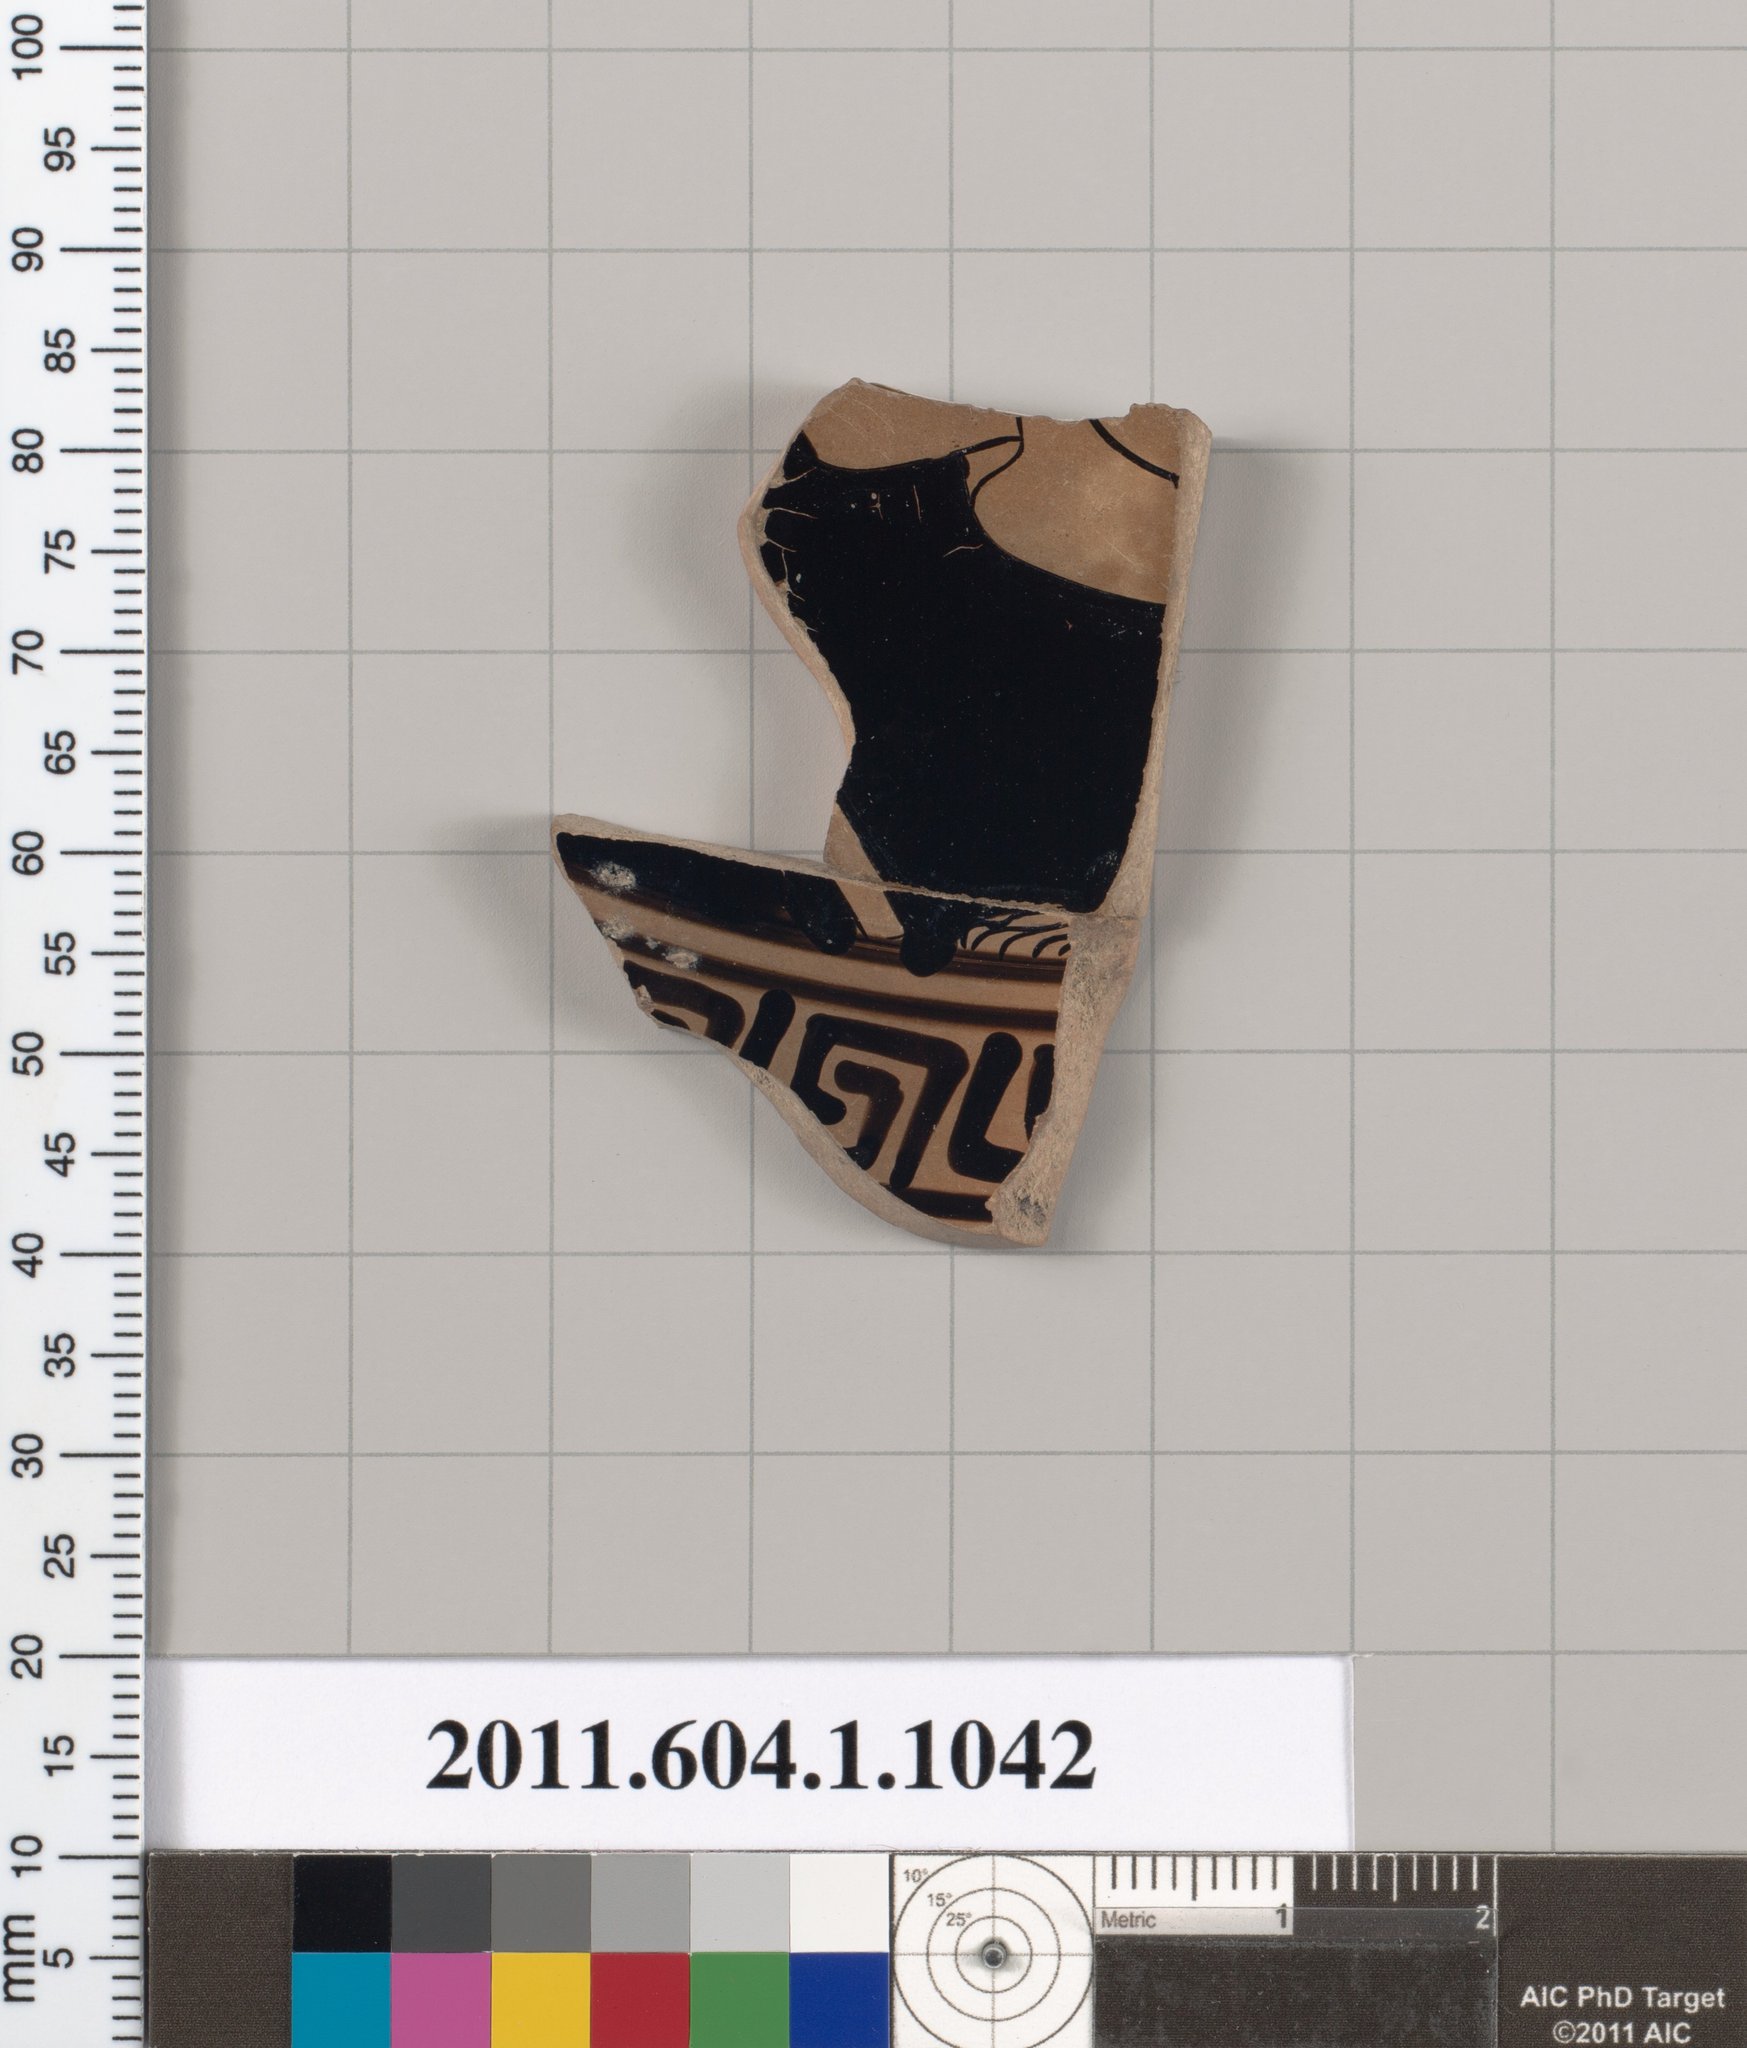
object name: kylix fragment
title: Terracotta fragment of a kylix (drinking cup)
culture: greek, attic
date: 490-480 BCE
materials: terracotta